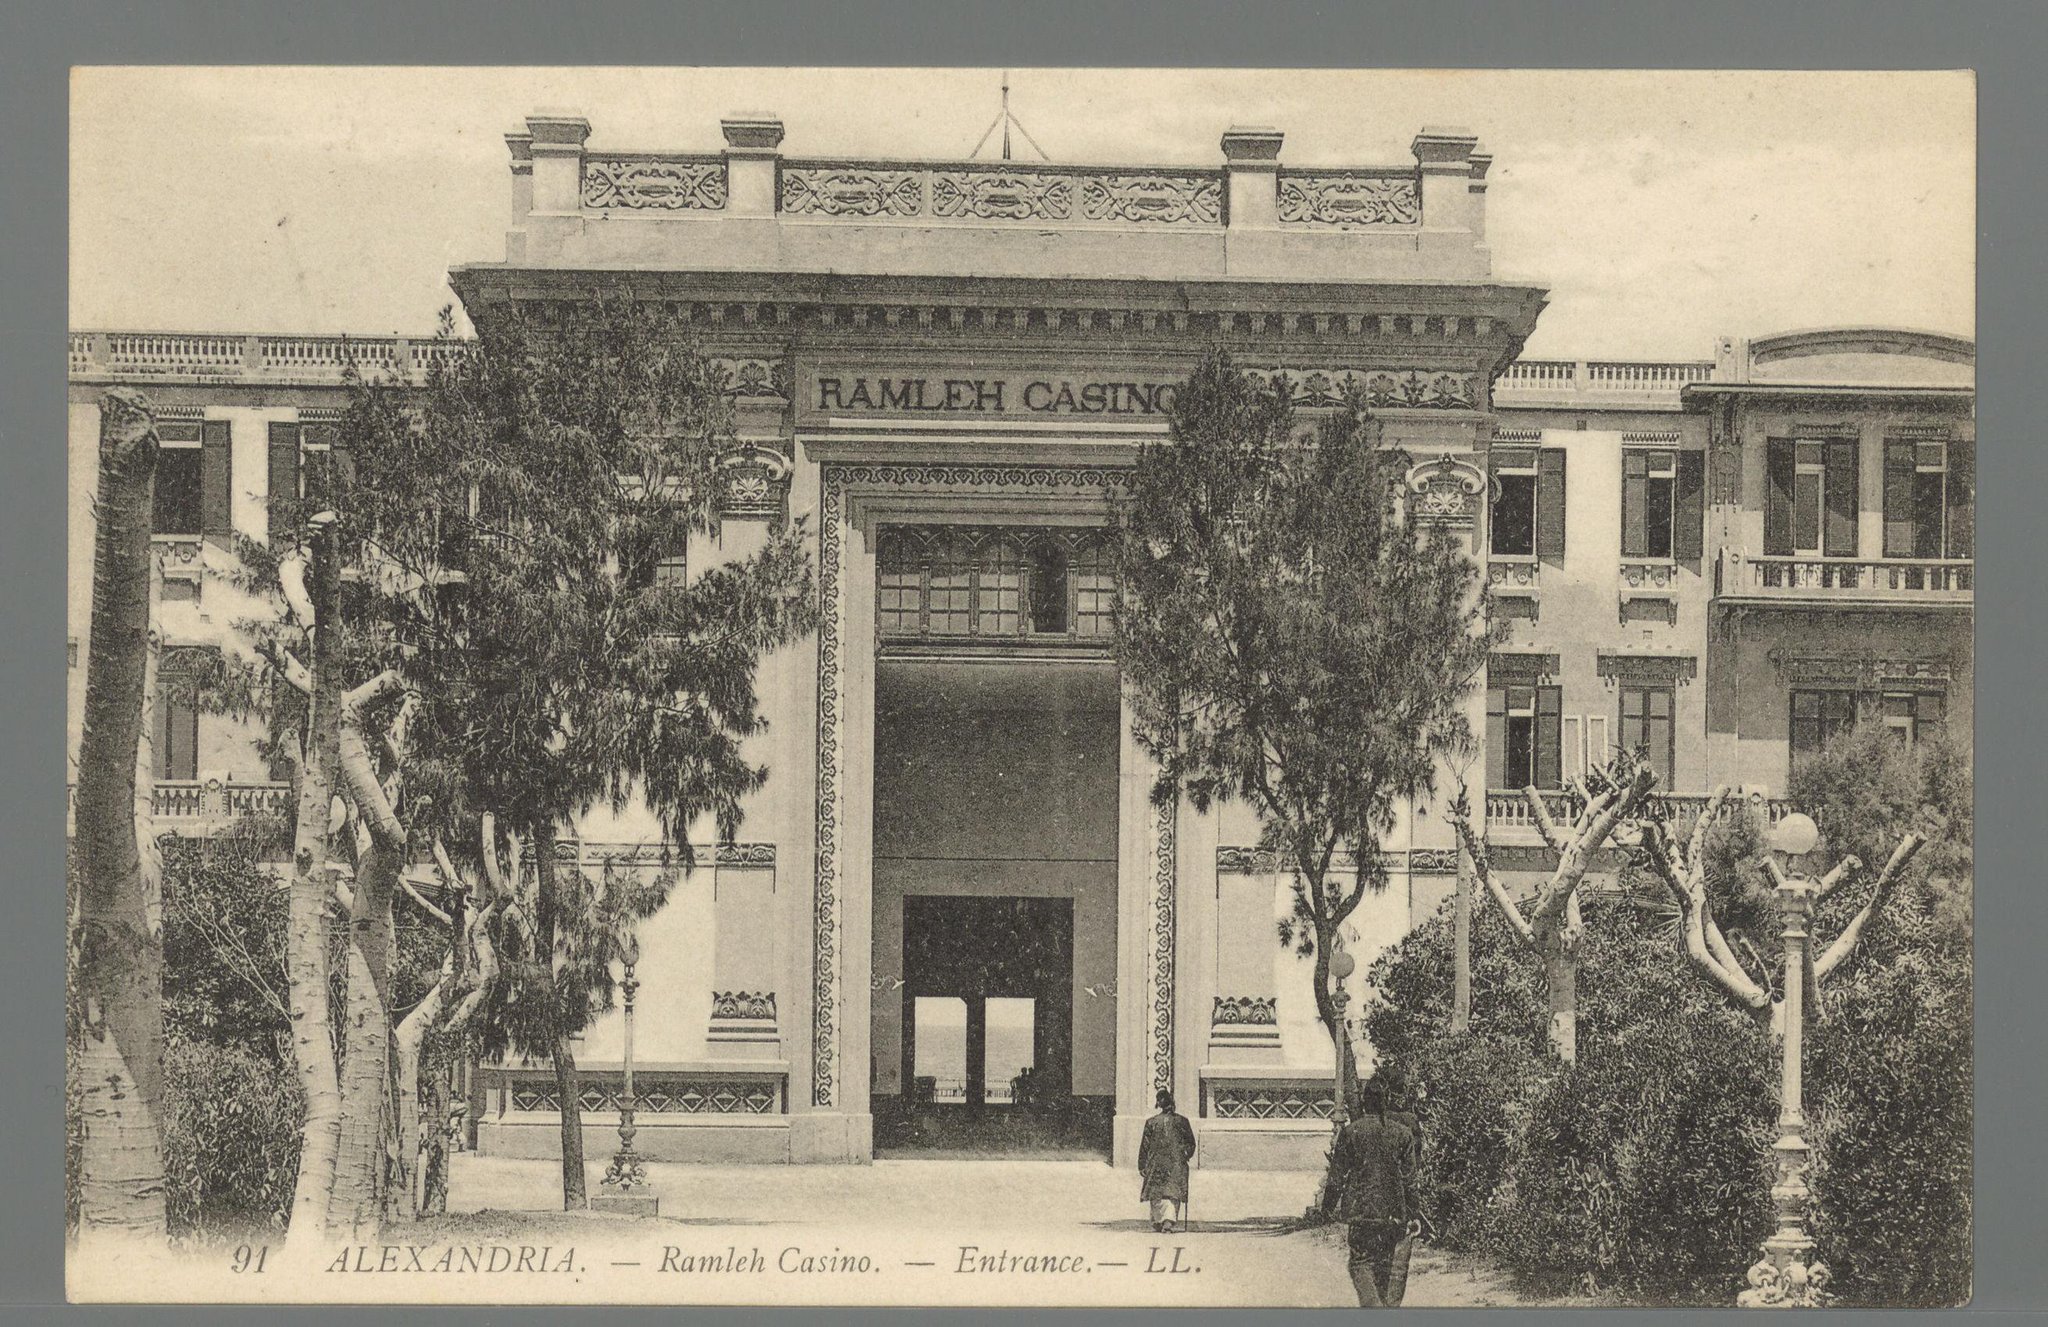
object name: photomechanical print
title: Alexandria - Ramleh Casino - Entrance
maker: Anonymous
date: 1907-1909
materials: cardboard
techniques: photograph, writing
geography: alexandria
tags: gate, entrance, casino